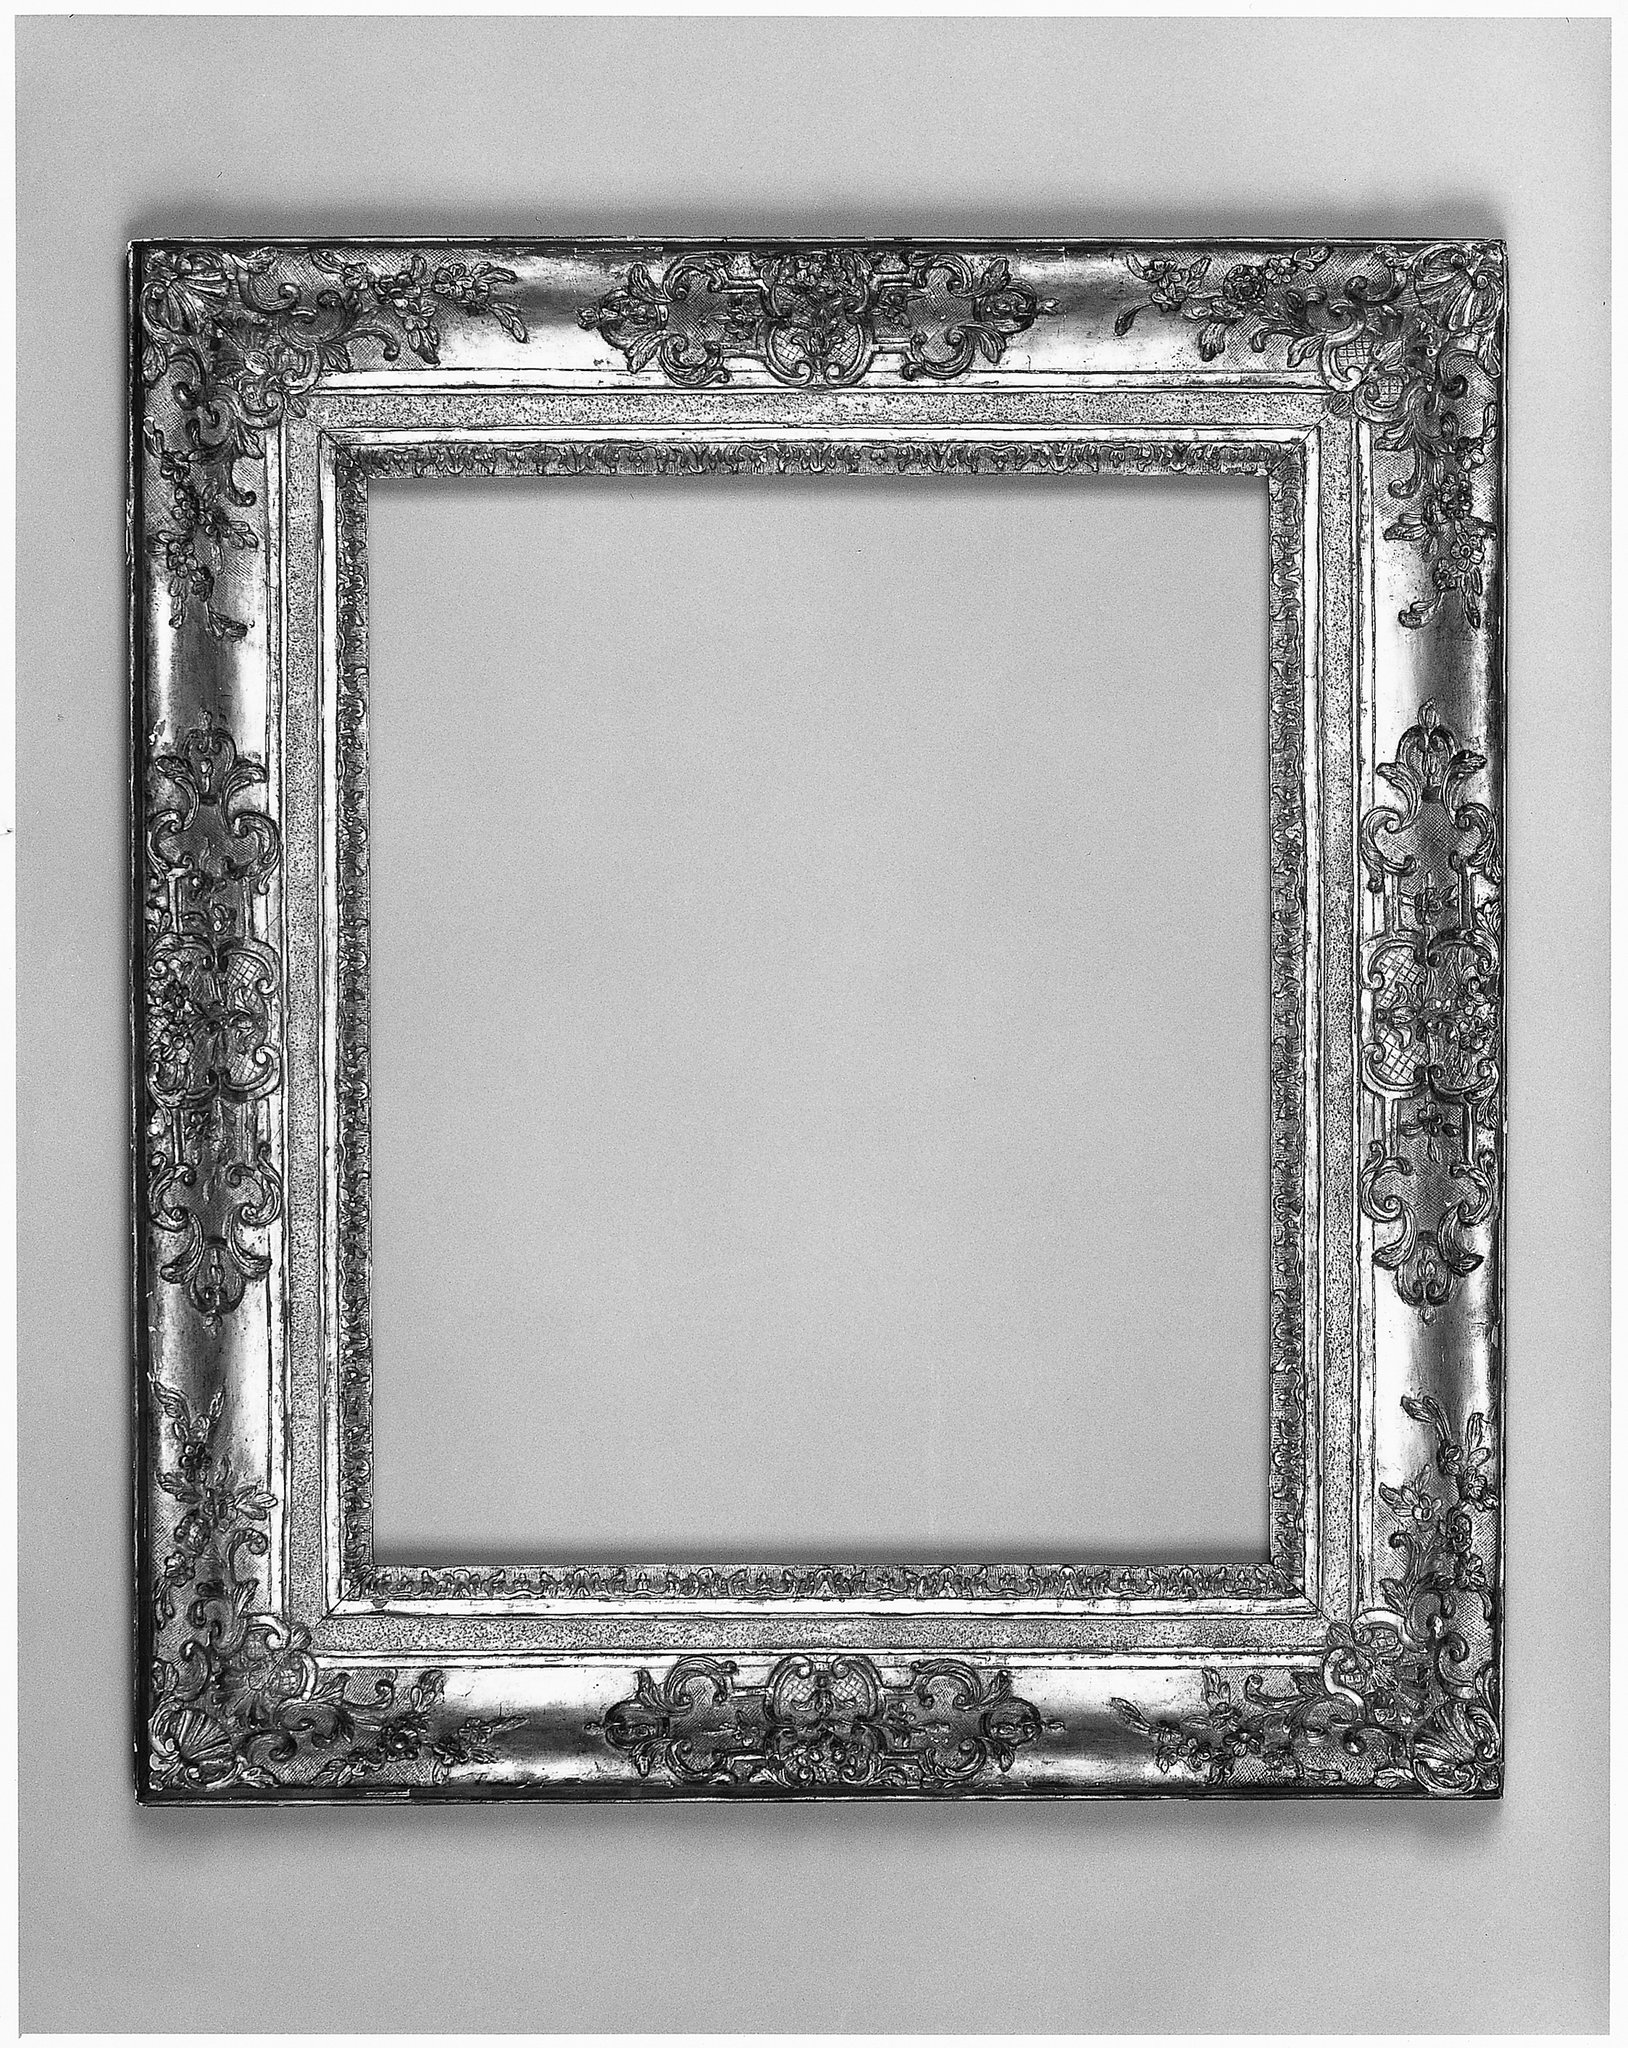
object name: frame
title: Ogee frame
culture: dutch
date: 1720-1730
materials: wood